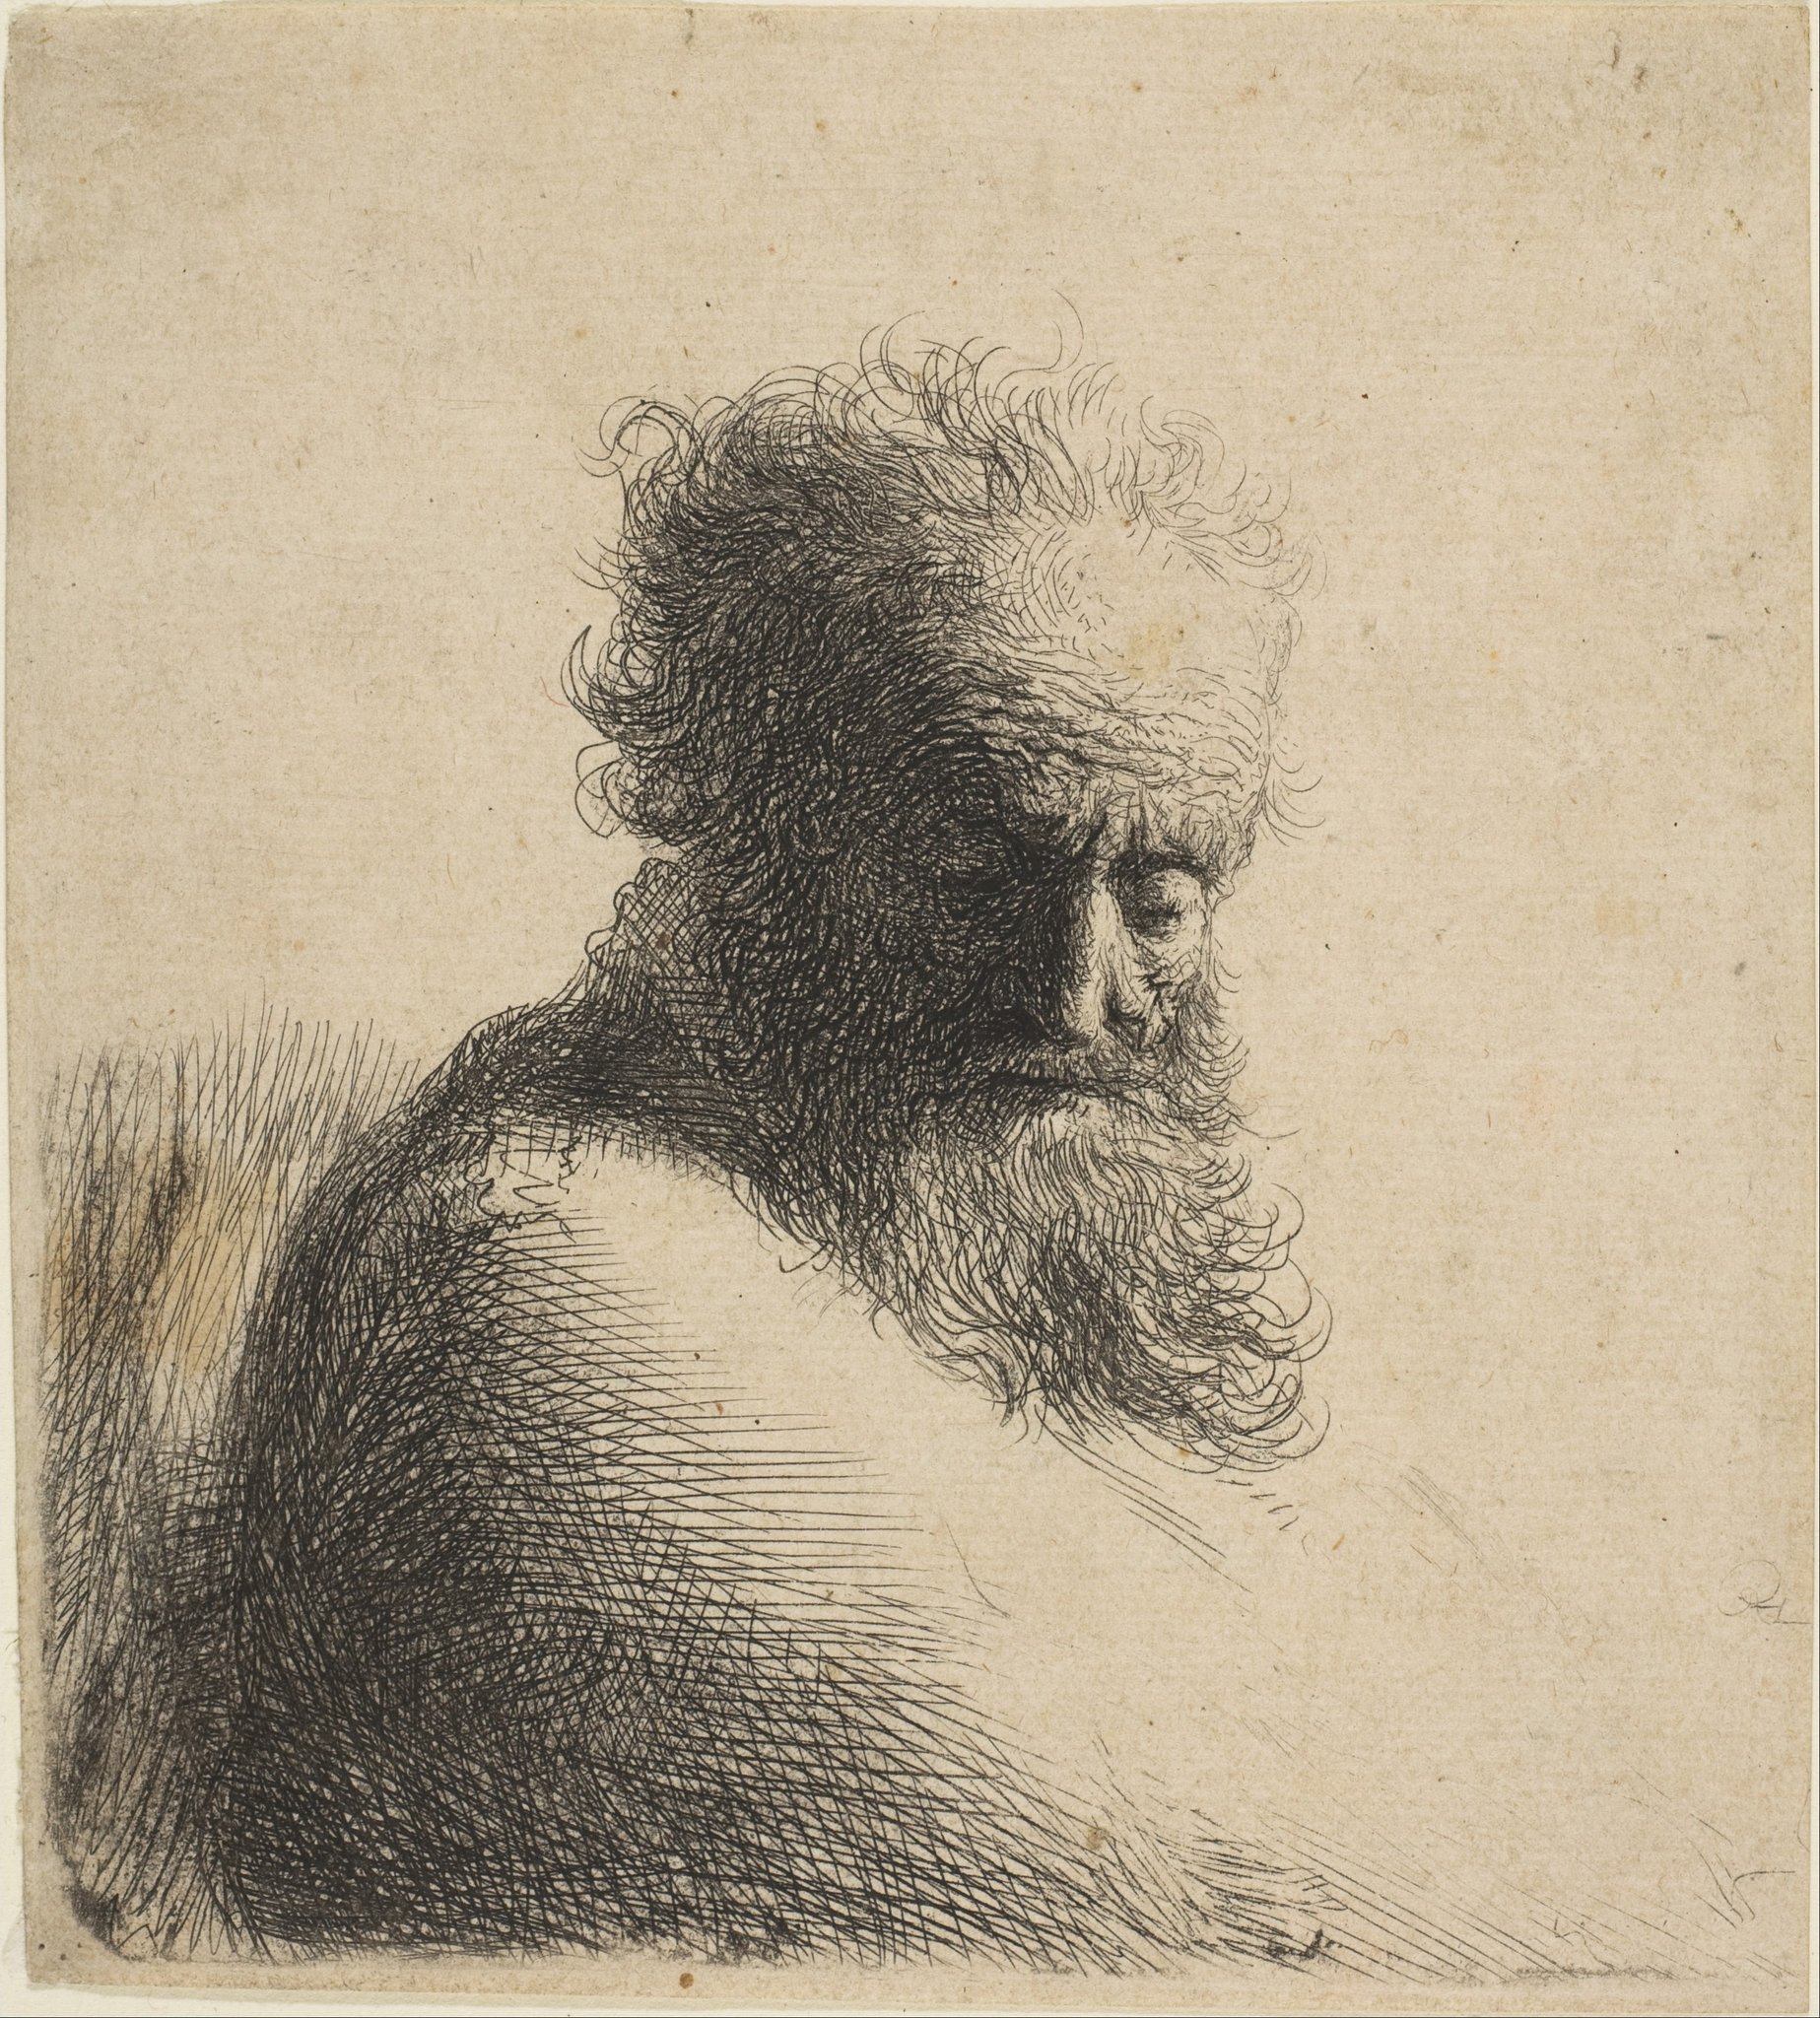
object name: print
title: Bust of an Old Bearded Man Looking Down, Three-Quarters Right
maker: rembrandt van rijn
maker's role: artist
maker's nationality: dutch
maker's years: 1606-1669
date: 1631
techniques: etching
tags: men,portraits